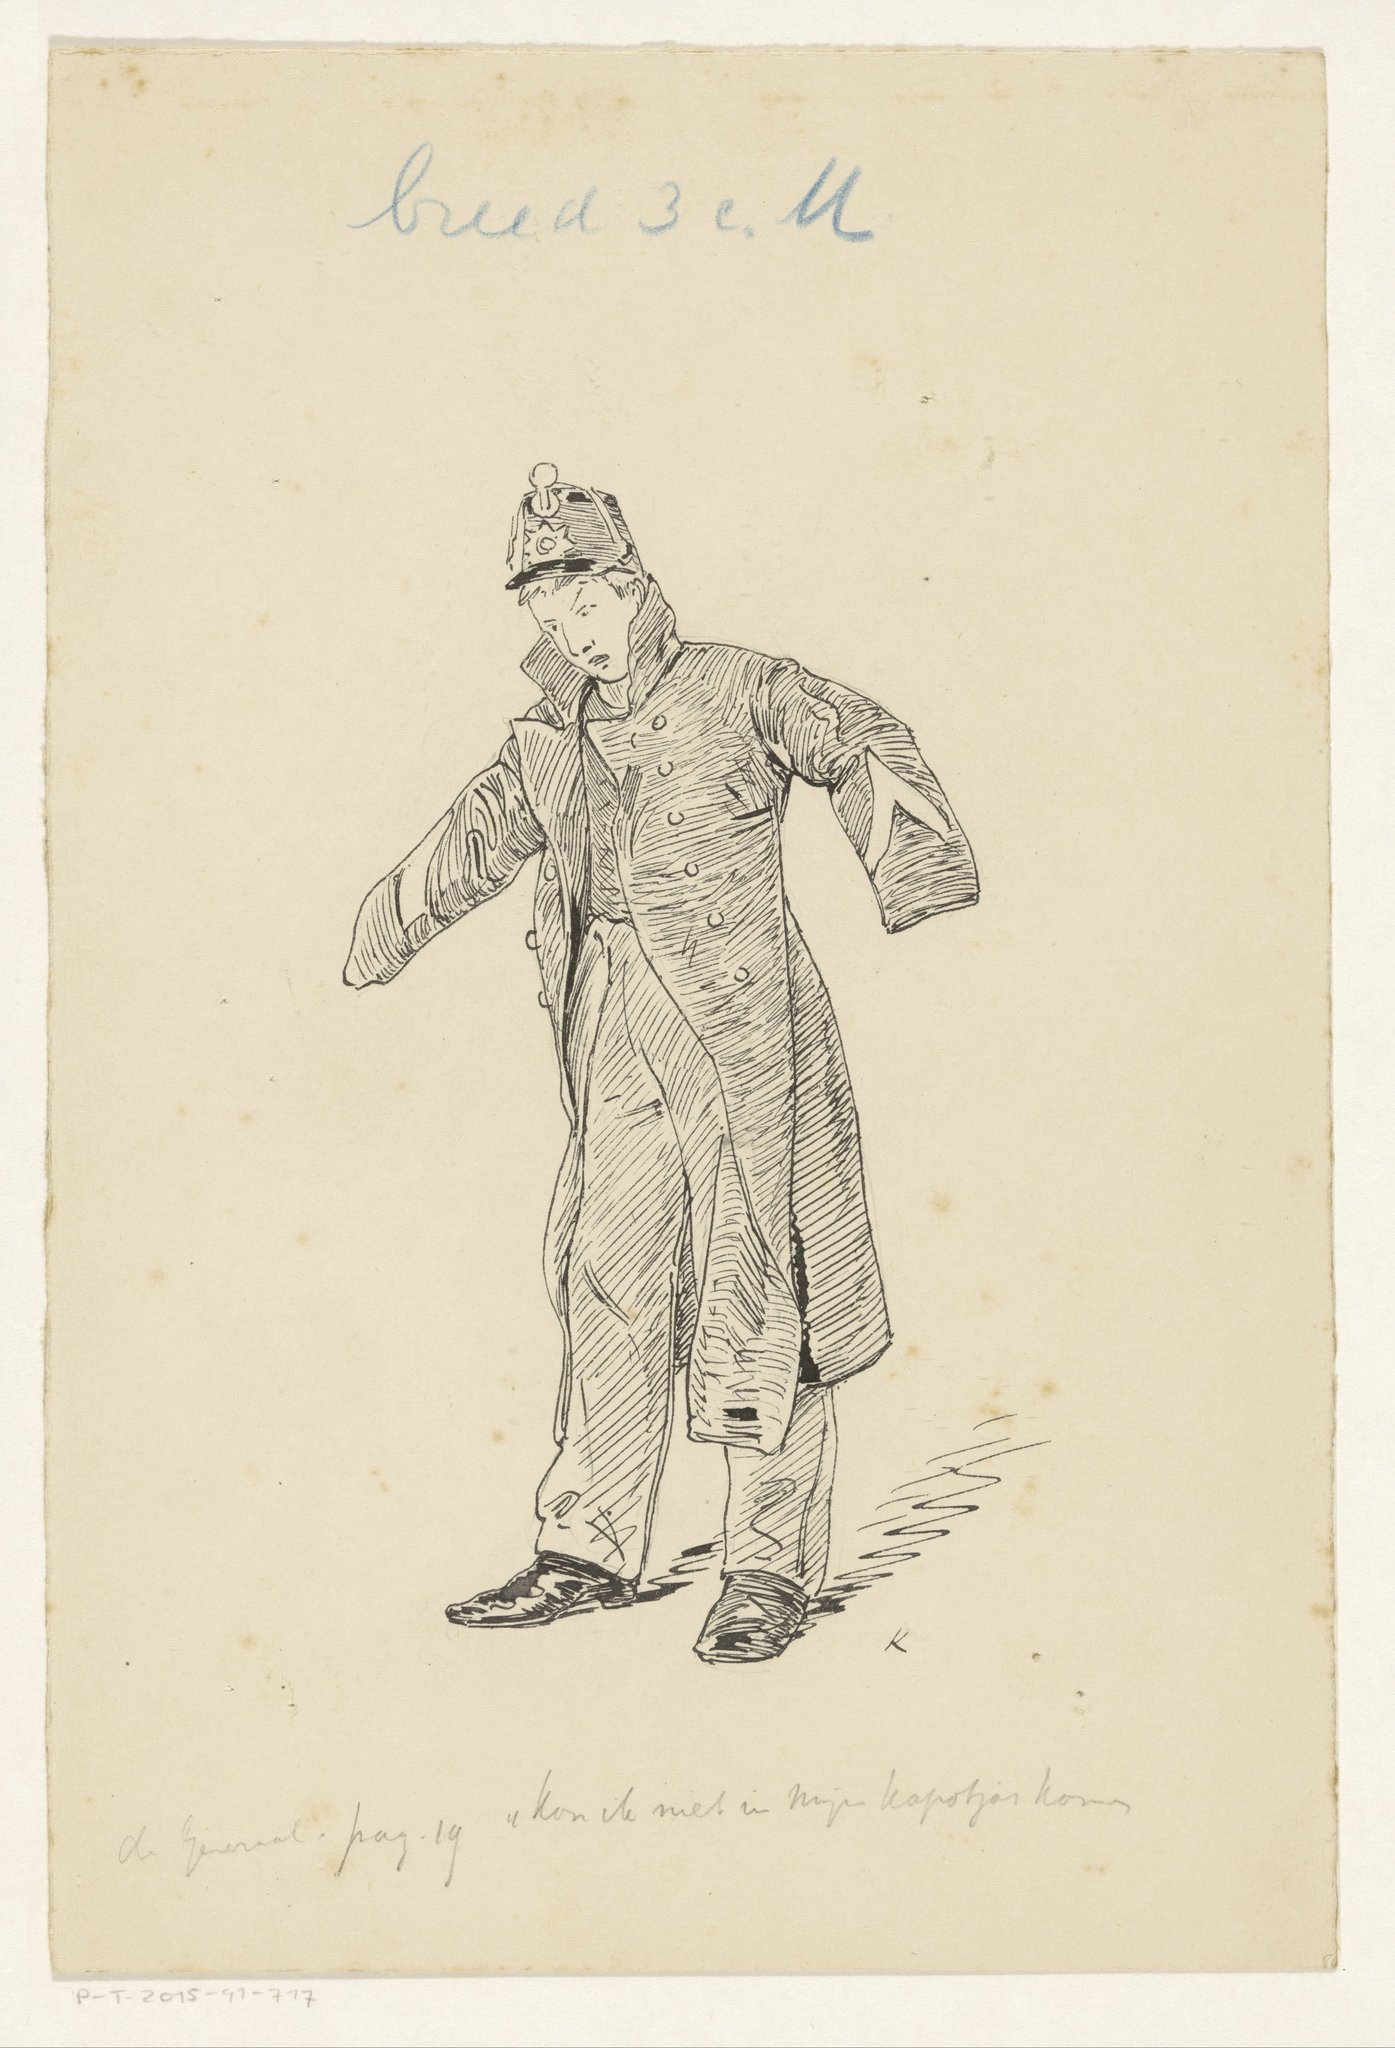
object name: boekillustratie ontwerp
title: Jongeman probeert zijn kapotjas aan te trekken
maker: heinrich m. krabbé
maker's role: draughtsman, print maker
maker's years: 1868-1931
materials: ink, paper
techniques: pen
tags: coat: overcoat (+ men's clothes), (military) uniforms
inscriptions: :, annotation: ‘de Generaal. pag. 19 "kon ik niet in mijn kapotjas komen"’, collector's mark: Lugt 2228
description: Een verbaasd kijkende jongeman staat met zijn armen uitgestrekt en probeert in de mouwen van zijn kapotjas (soldatenoverjas) te komen.